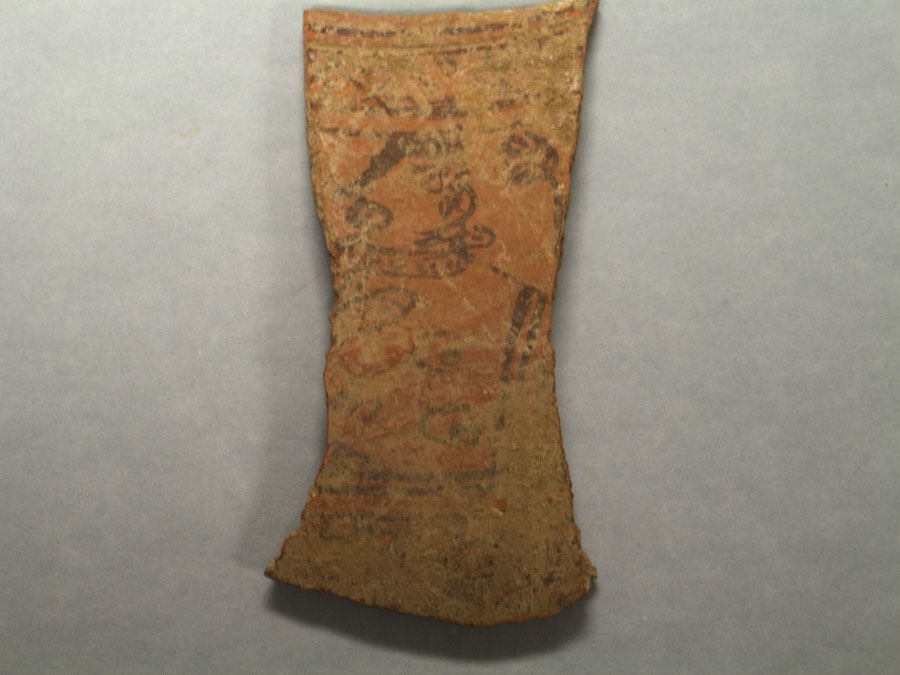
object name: shard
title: Shard: Bust and Profile of a Figure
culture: pakistani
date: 301-500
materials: terracotta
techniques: painting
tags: gandhara